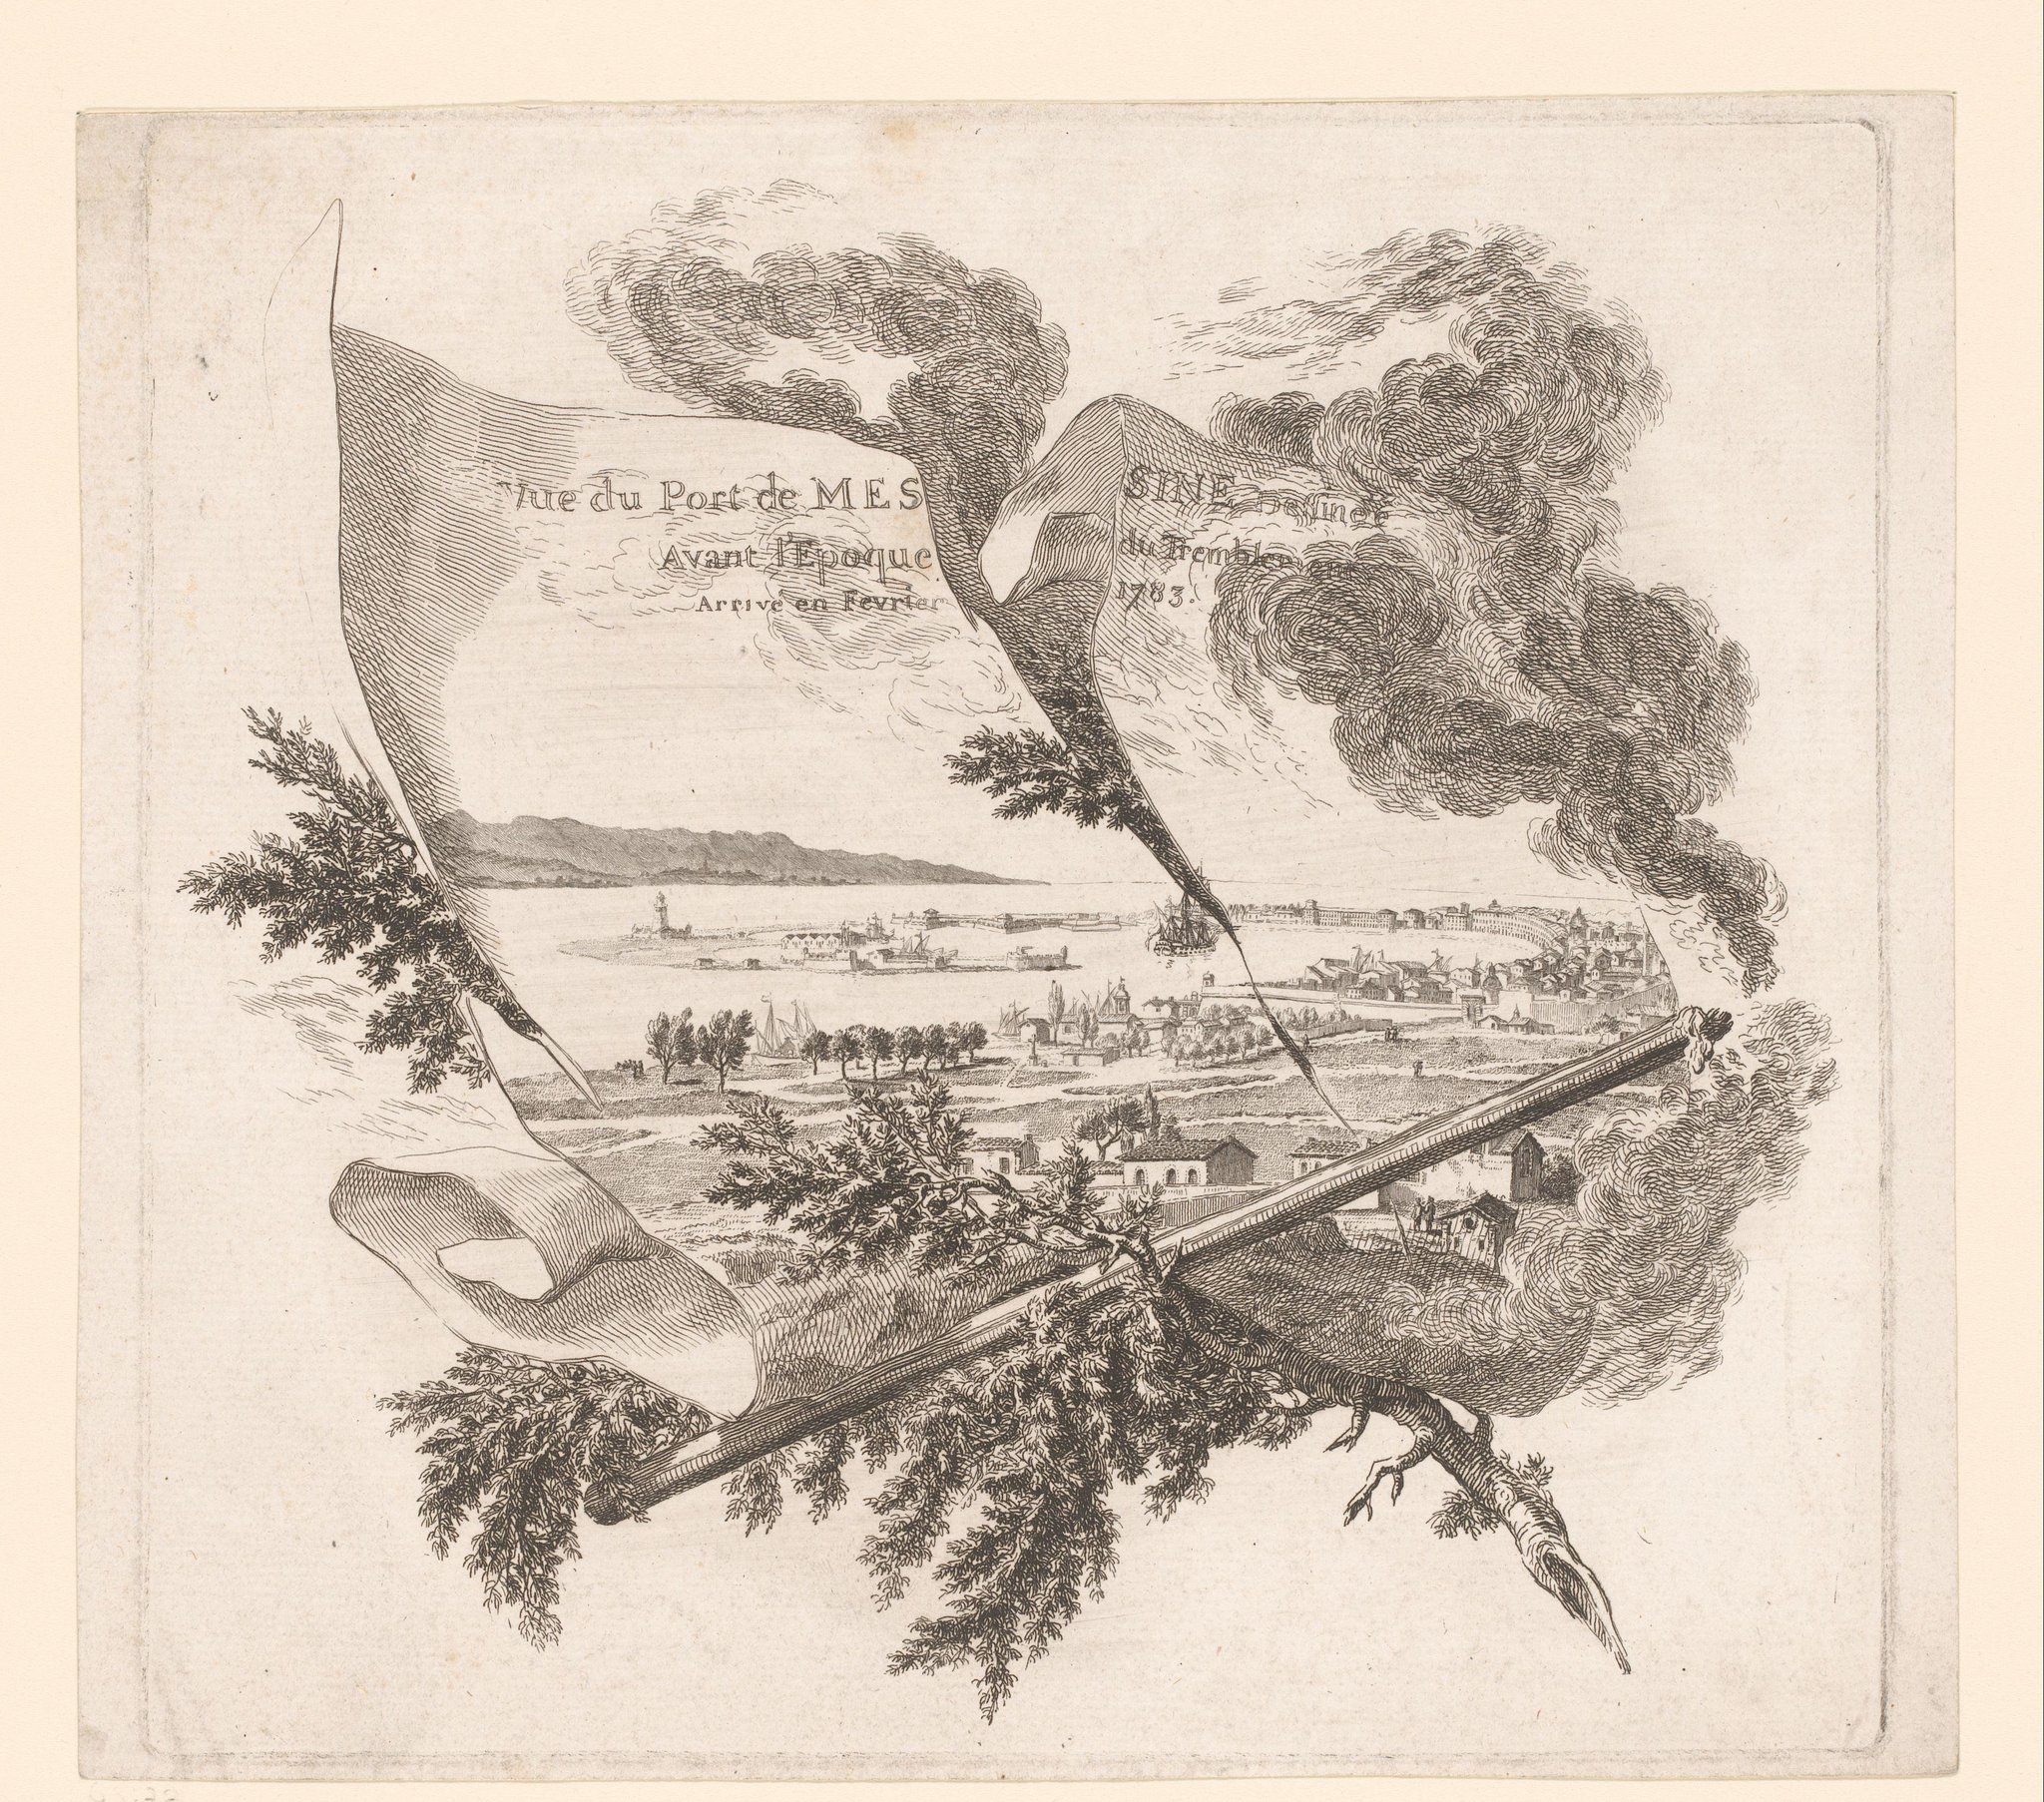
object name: print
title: Zicht op de haven van Messina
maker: pierre philippe choffard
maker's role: print maker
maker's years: 1730-1809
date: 1783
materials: paper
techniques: engraving, etching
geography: france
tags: harbour, foliage, tendrils, branches ~ ornament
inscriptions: collector's mark: Lugt 2228, collector's mark: Lugt 2760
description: Mogelijk prent uit: Saint Non, Jean Claude Richard de. Voyage pittoresque à Naples et en Sicile. Parijs: Dufour, Nicolas (?), 1781-1786.